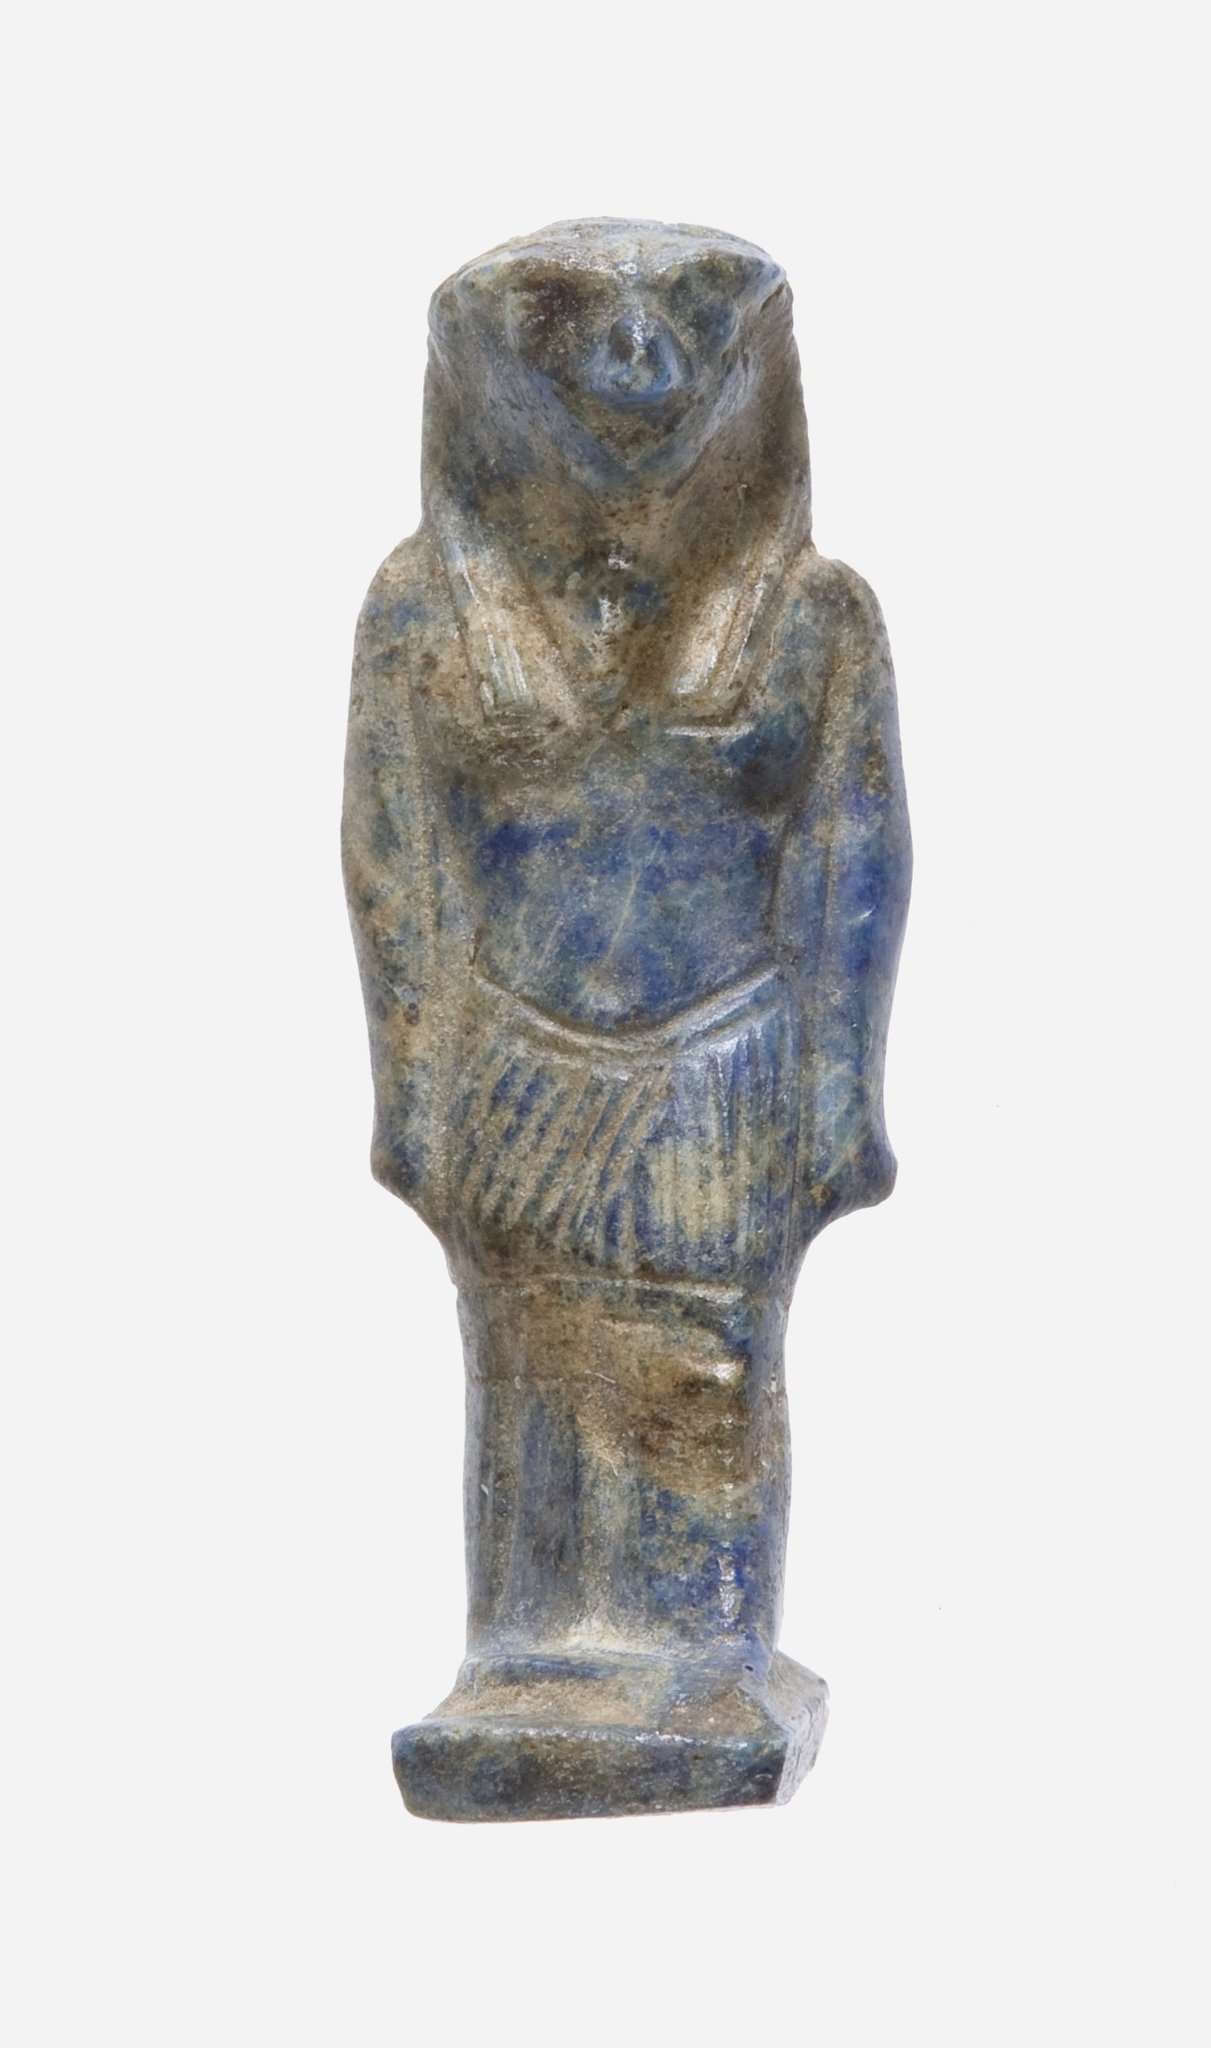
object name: amulet, son of horus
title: Horus Amulet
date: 664-332 BCE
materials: lapis lazuli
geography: egypt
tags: horus